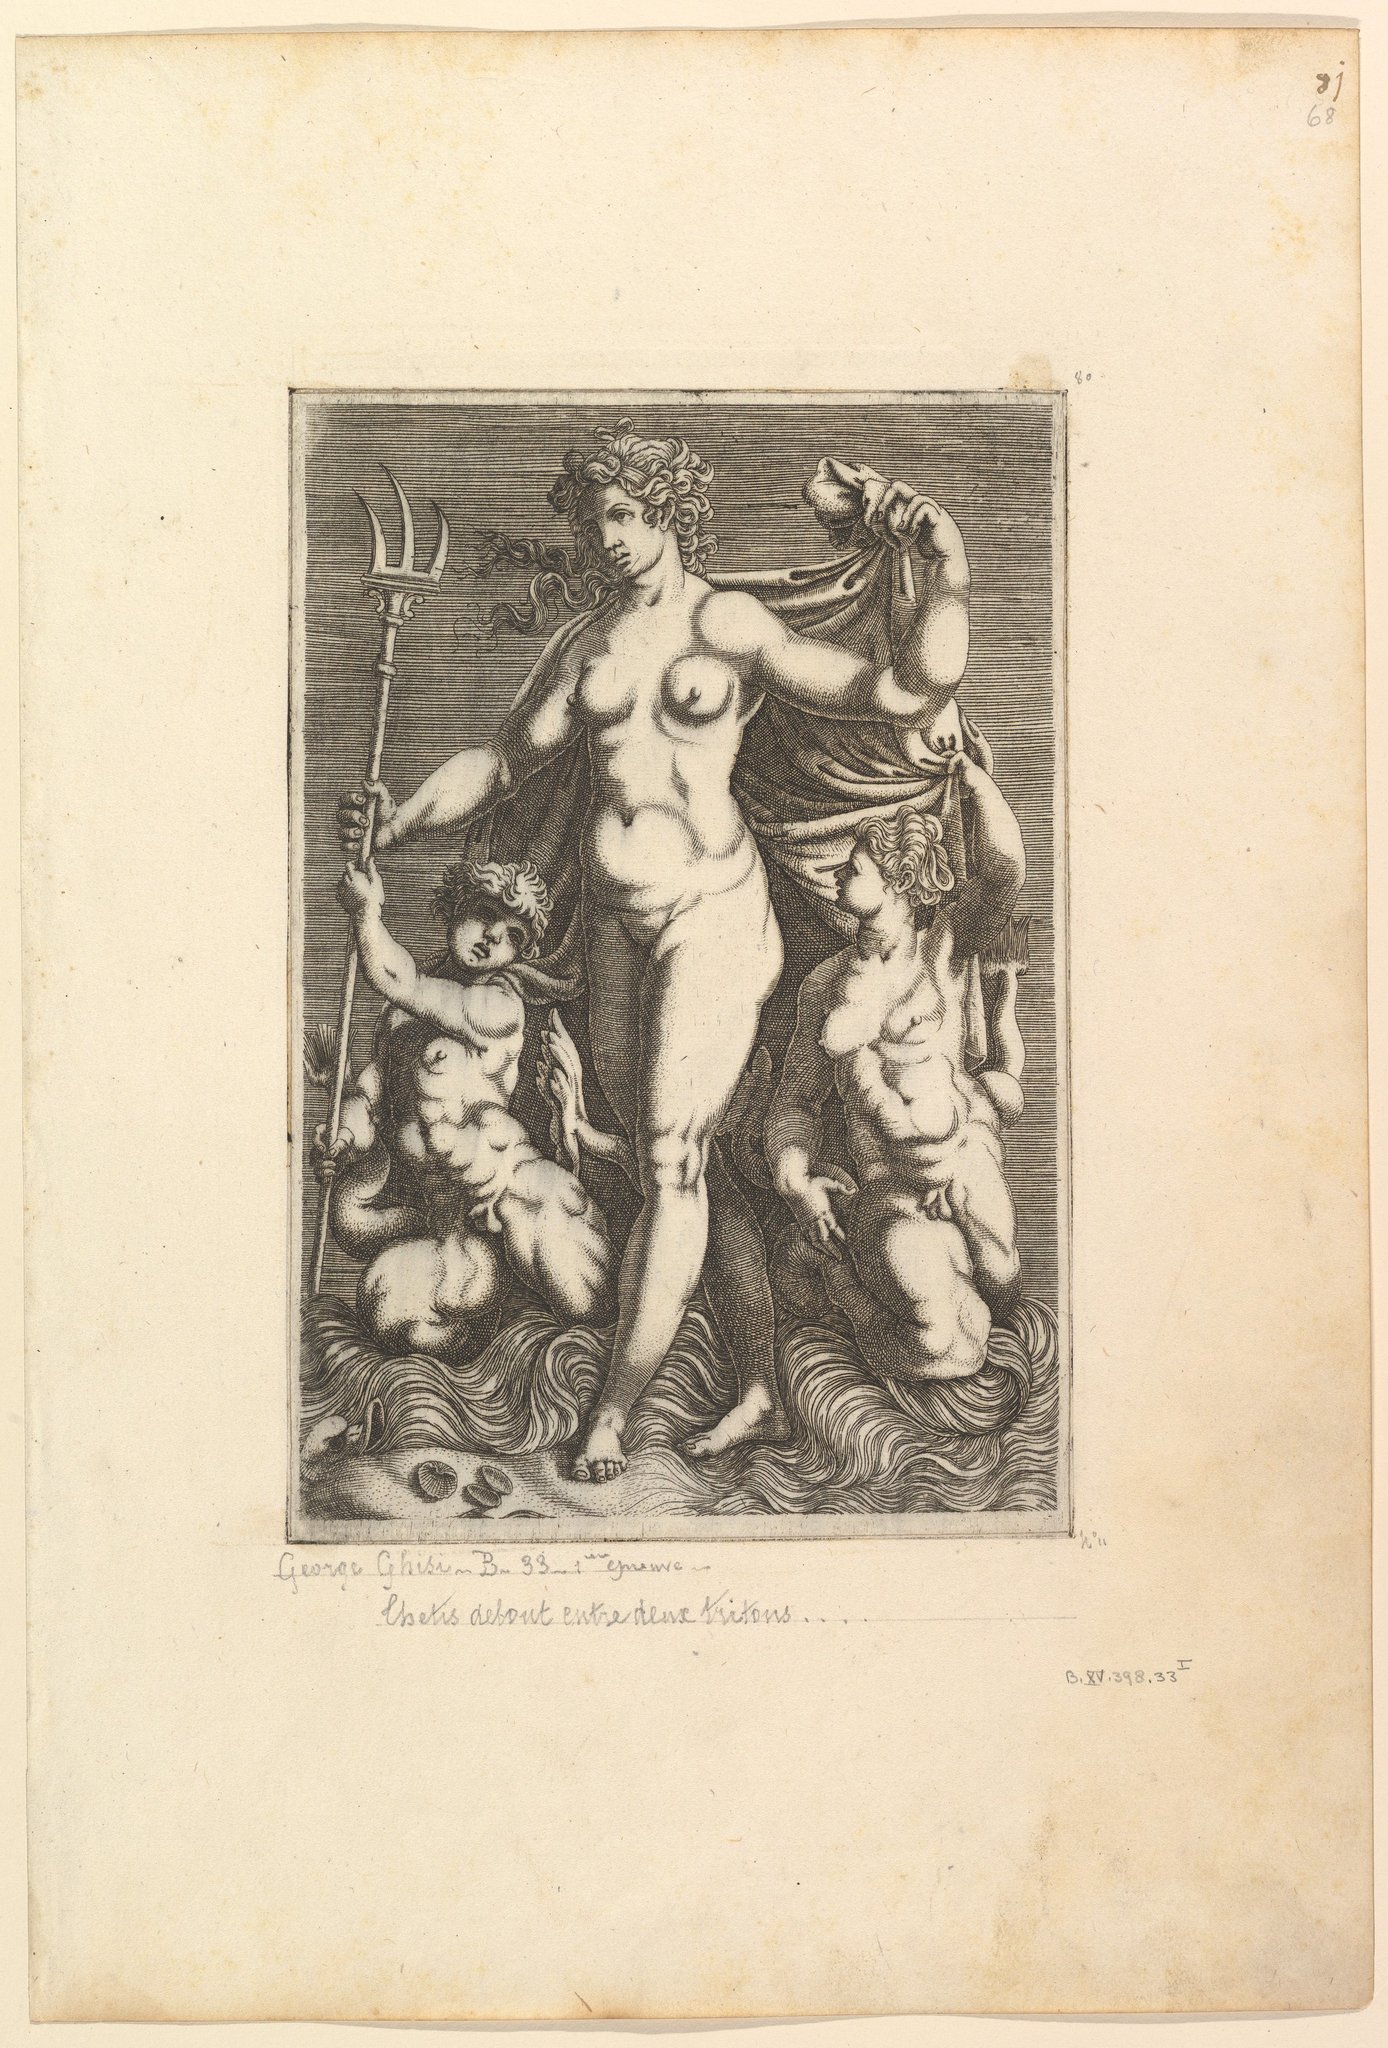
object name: print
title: Thetis Standing with Two Tritons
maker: anonymous, italian?, 16th century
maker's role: artist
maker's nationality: italian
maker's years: 1500-1600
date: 1550-1600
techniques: engraving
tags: male nudes,female nudes,triton